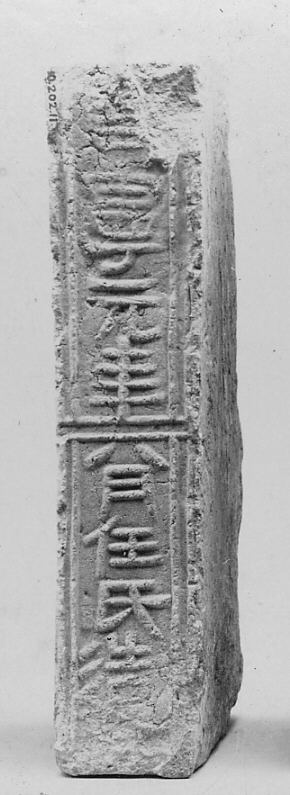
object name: tile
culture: chinese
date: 221 BCE-220 CE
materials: earthenware